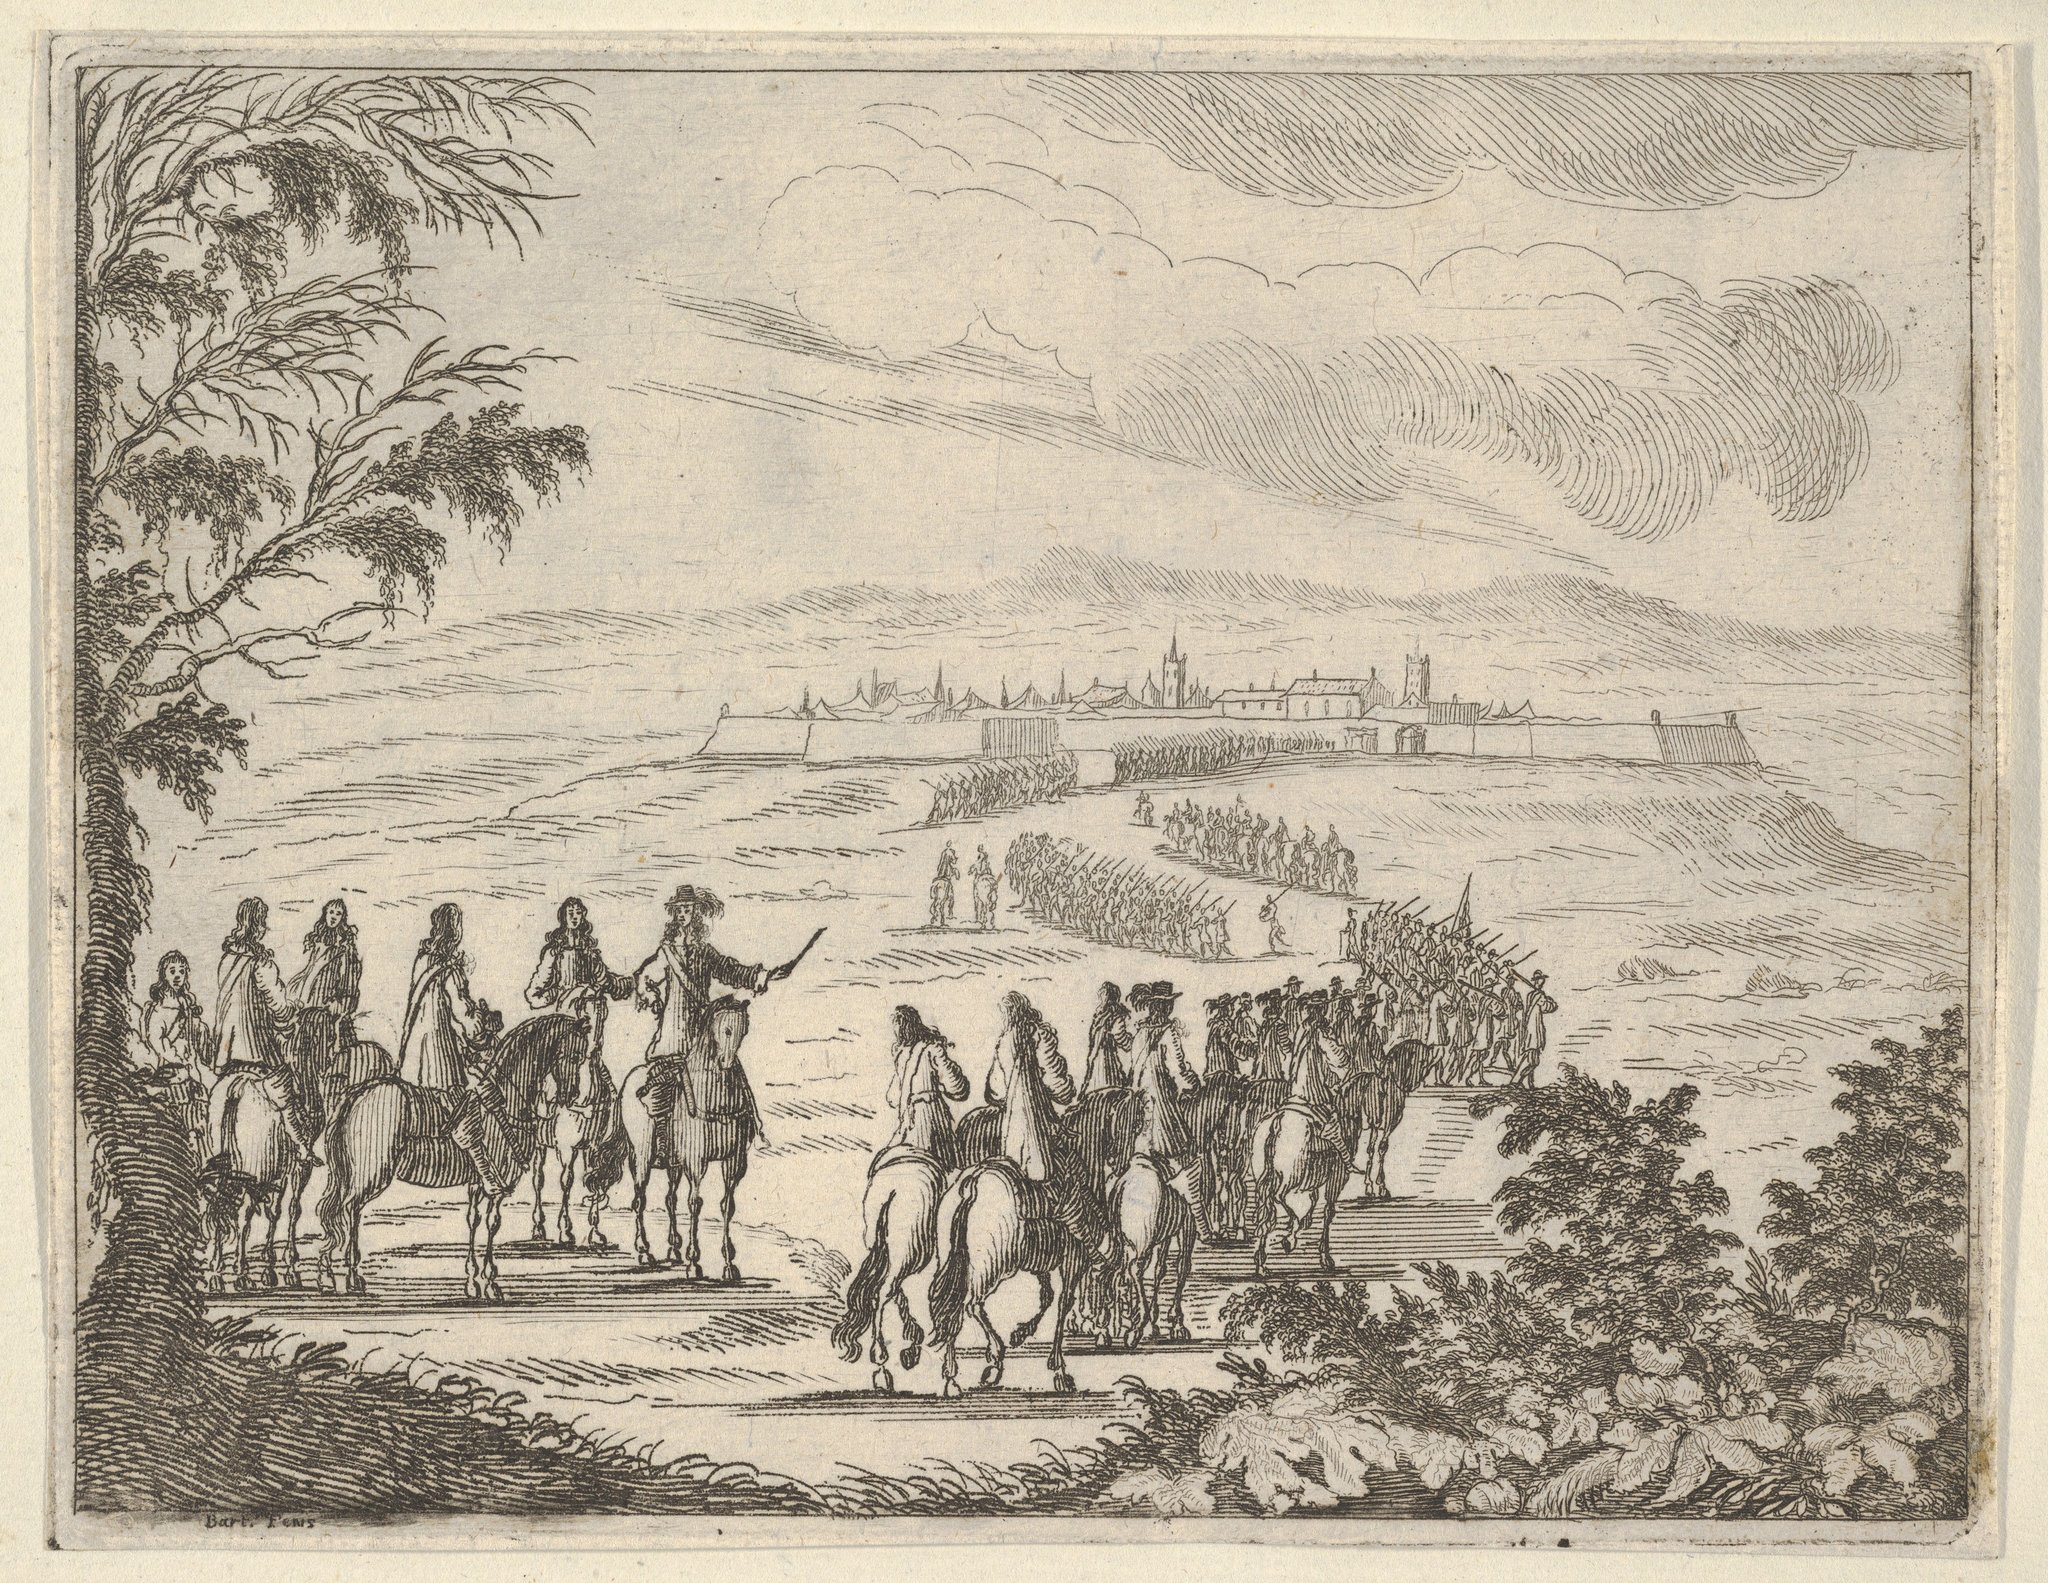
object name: print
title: Francesco I d'Este Goes to Pinarola for the Security of his States, from "L'Idea di un Principe ed Eroe Cristiano in Francesco I d'Este, di Modena e Reggio Duca VIII [...]"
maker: bartolomeo fenice (fénis)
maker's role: artist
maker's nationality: italian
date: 1659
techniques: etching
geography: italy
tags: soldiers,horses